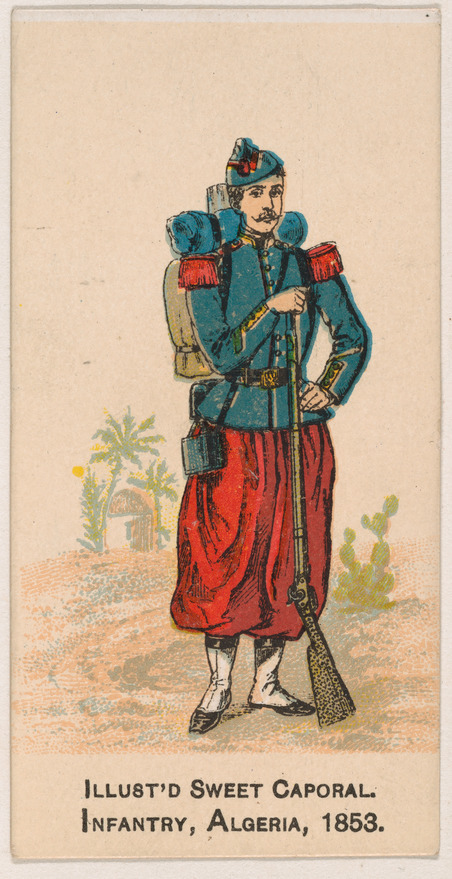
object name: print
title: Infantry, Algeria, 1853, from the Military Series (N224) issued by Kinney Tobacco Company to promote Sweet Caporal Cigarettes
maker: kinney brothers tobacco company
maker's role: publisher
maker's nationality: american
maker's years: 1869-2011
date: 1888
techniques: color lithograph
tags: military,men